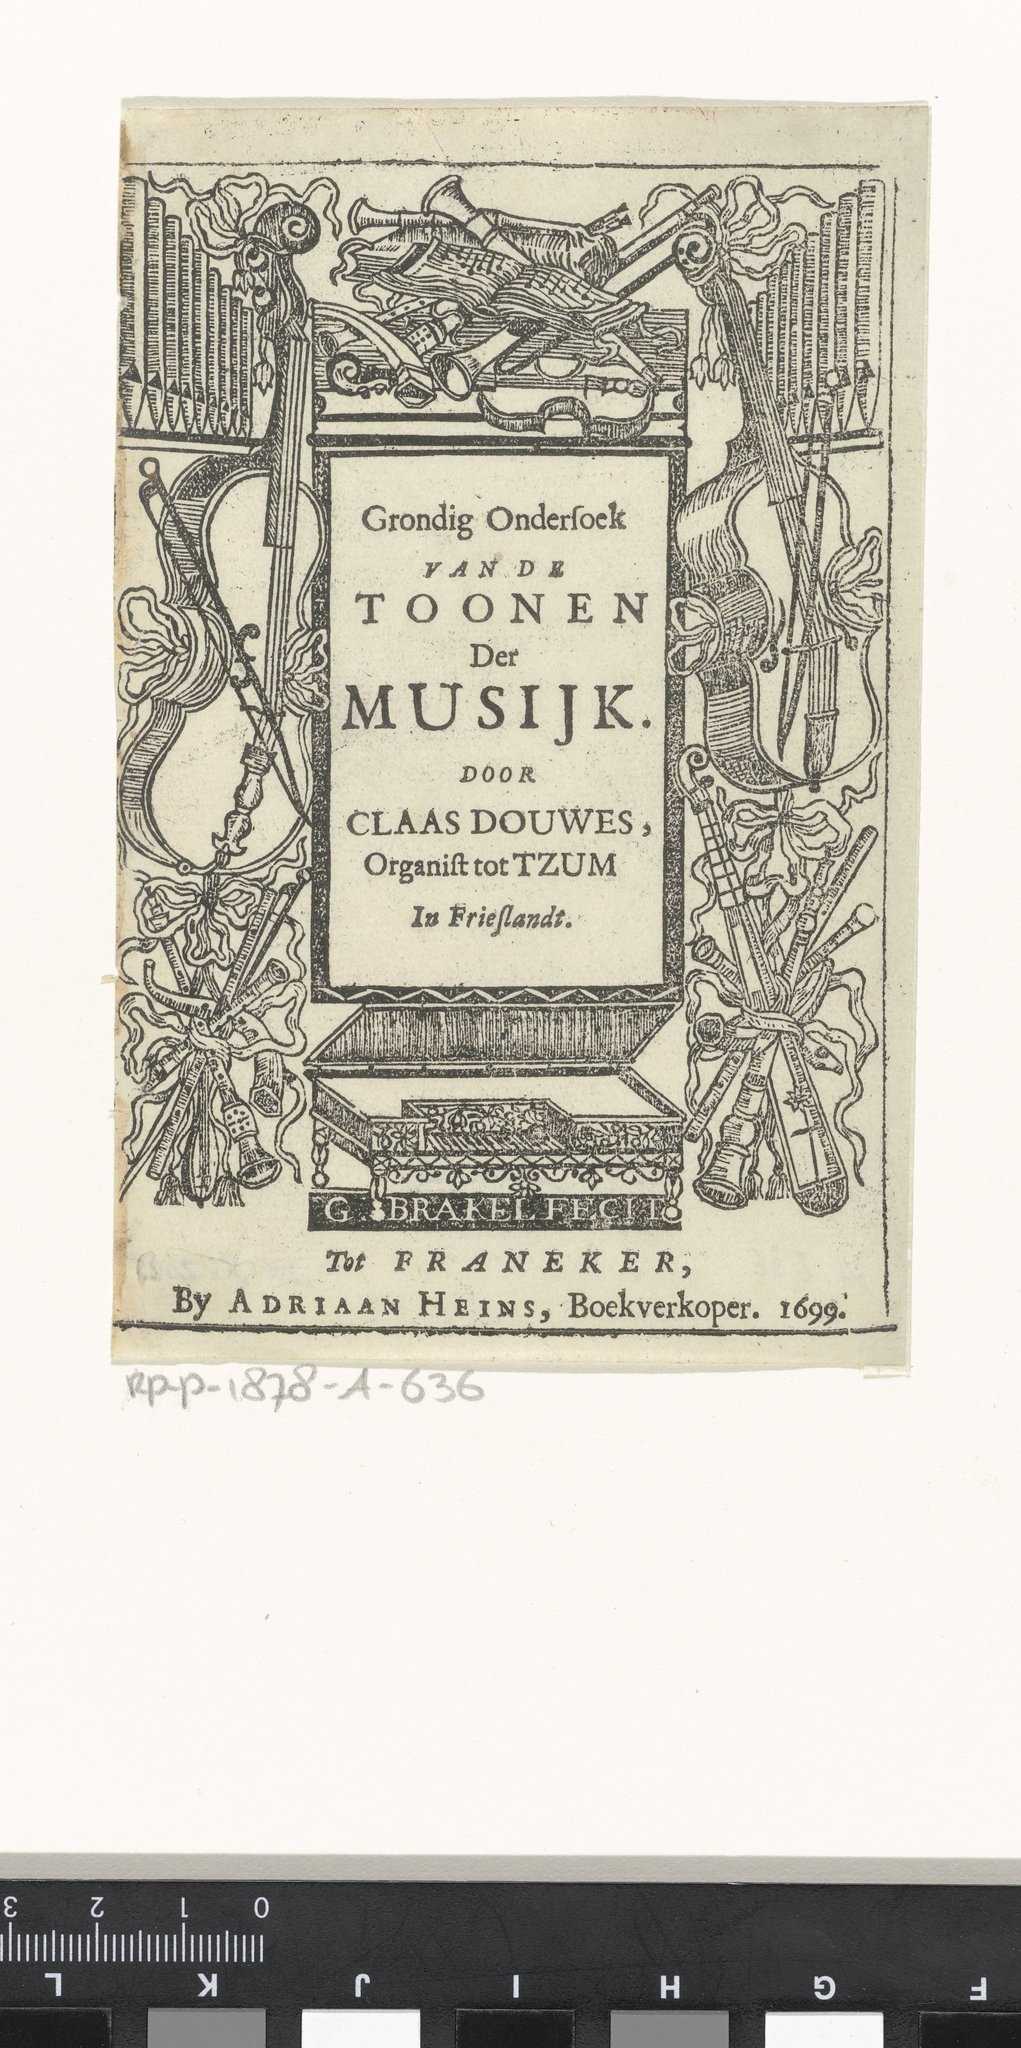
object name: print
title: Titelpagina voor: Klaas Douwes, Grondig ondersoek van de toonen der musijk, 1699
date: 1699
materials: paper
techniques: letterpress printing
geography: netherlands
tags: violin, fiddle, viola, violoncello; double bass, wind instruments, keyboard instruments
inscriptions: collector's mark: Lugt 2228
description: Titelpagina voor: Douwes, Klaas. Grondig ondersoek van de toonen der musijk. Franeker: Adriaan Heins, 1699.